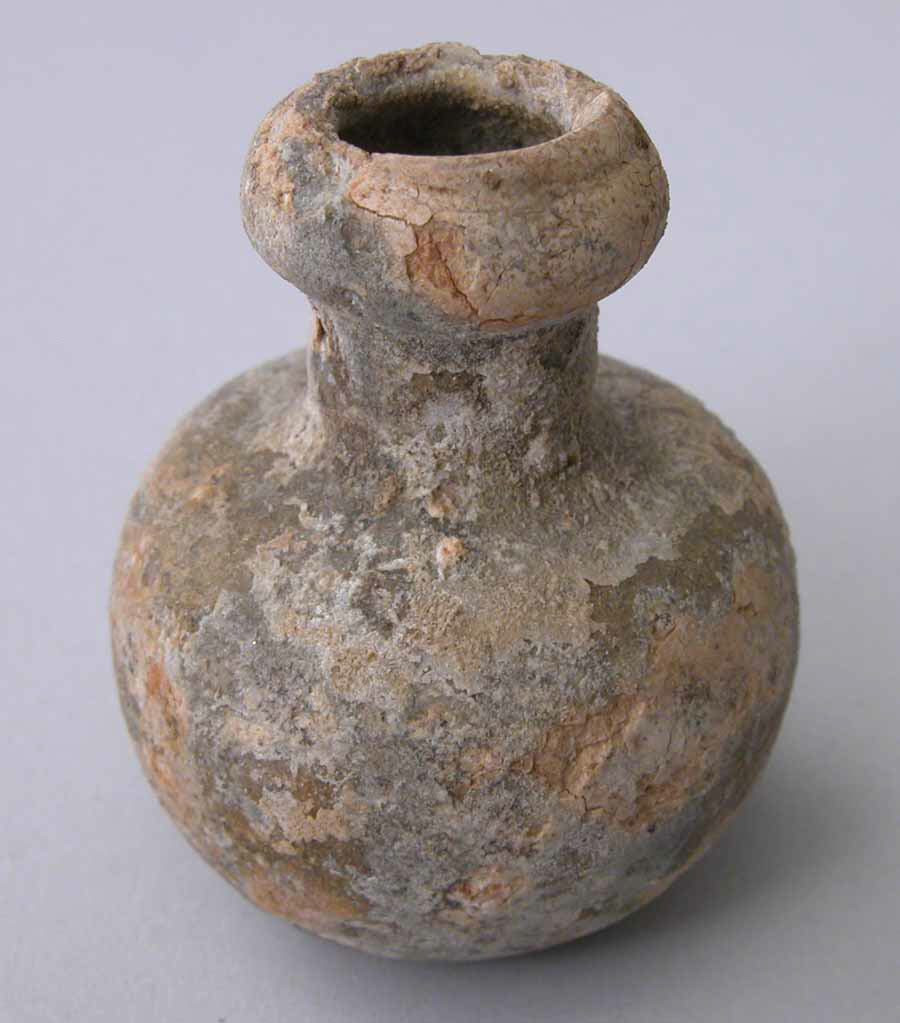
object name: bottle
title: Miniature Bottle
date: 901-1100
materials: glass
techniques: glassblowing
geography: iran